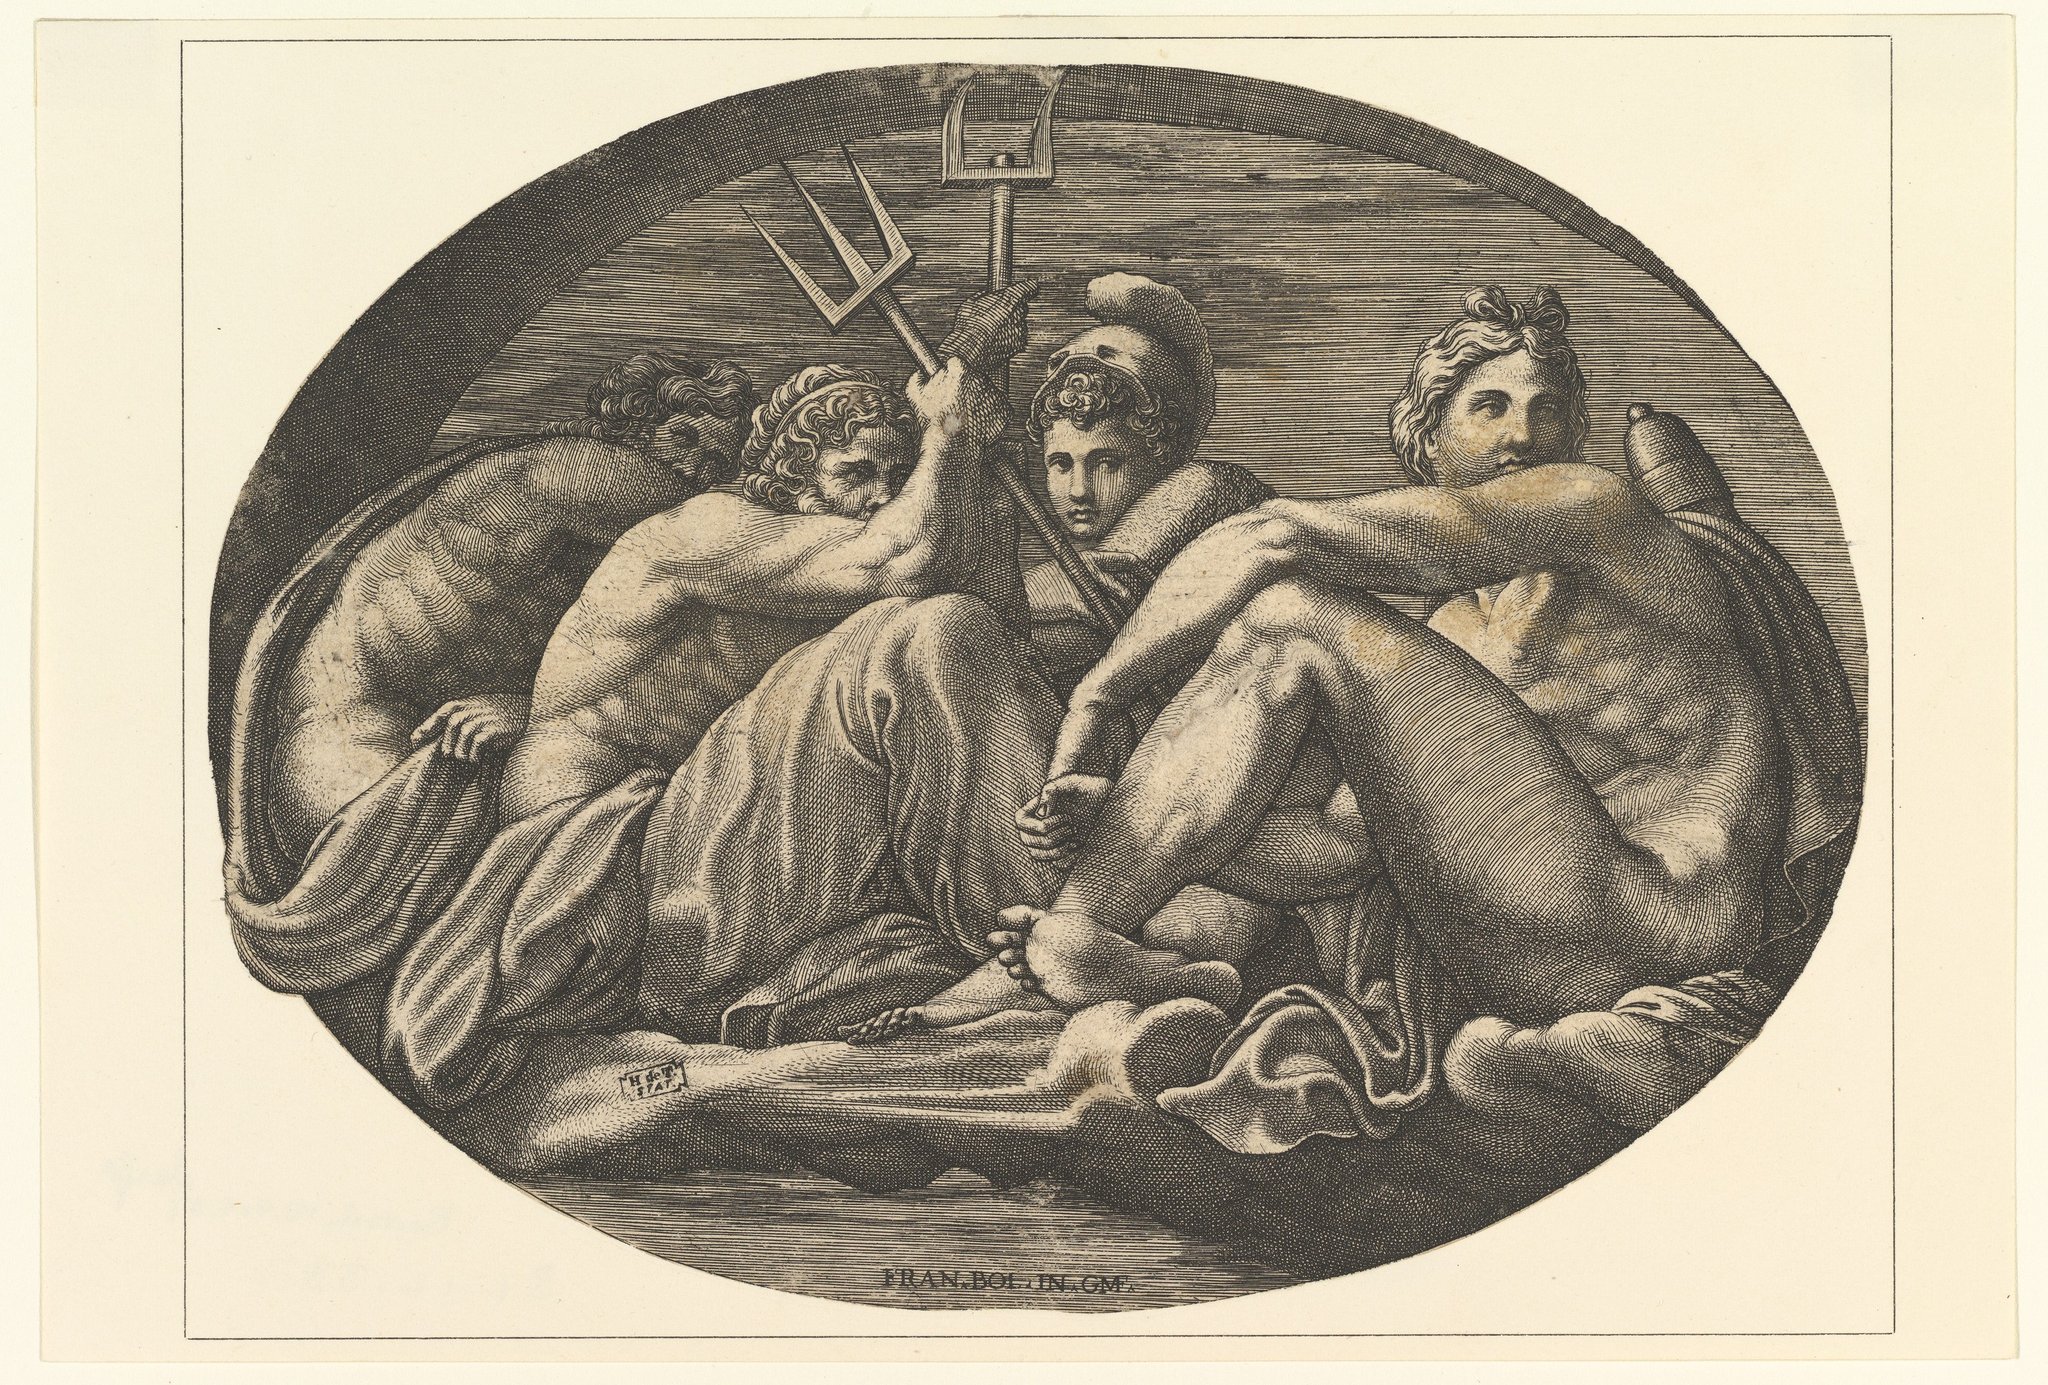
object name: print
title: Pluto, Neptune, Minerva, and Apollo, from a series of eight compositions after Francesco Primaticcio's designs for the ceiling of the Ulysses Gallery (destroyed 1738–39) at Fontainebleau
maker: giorgio ghisi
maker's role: artist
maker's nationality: italian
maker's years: 1515-1582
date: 1560-1569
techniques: engraving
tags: apollo,minerva,neptune,pluto